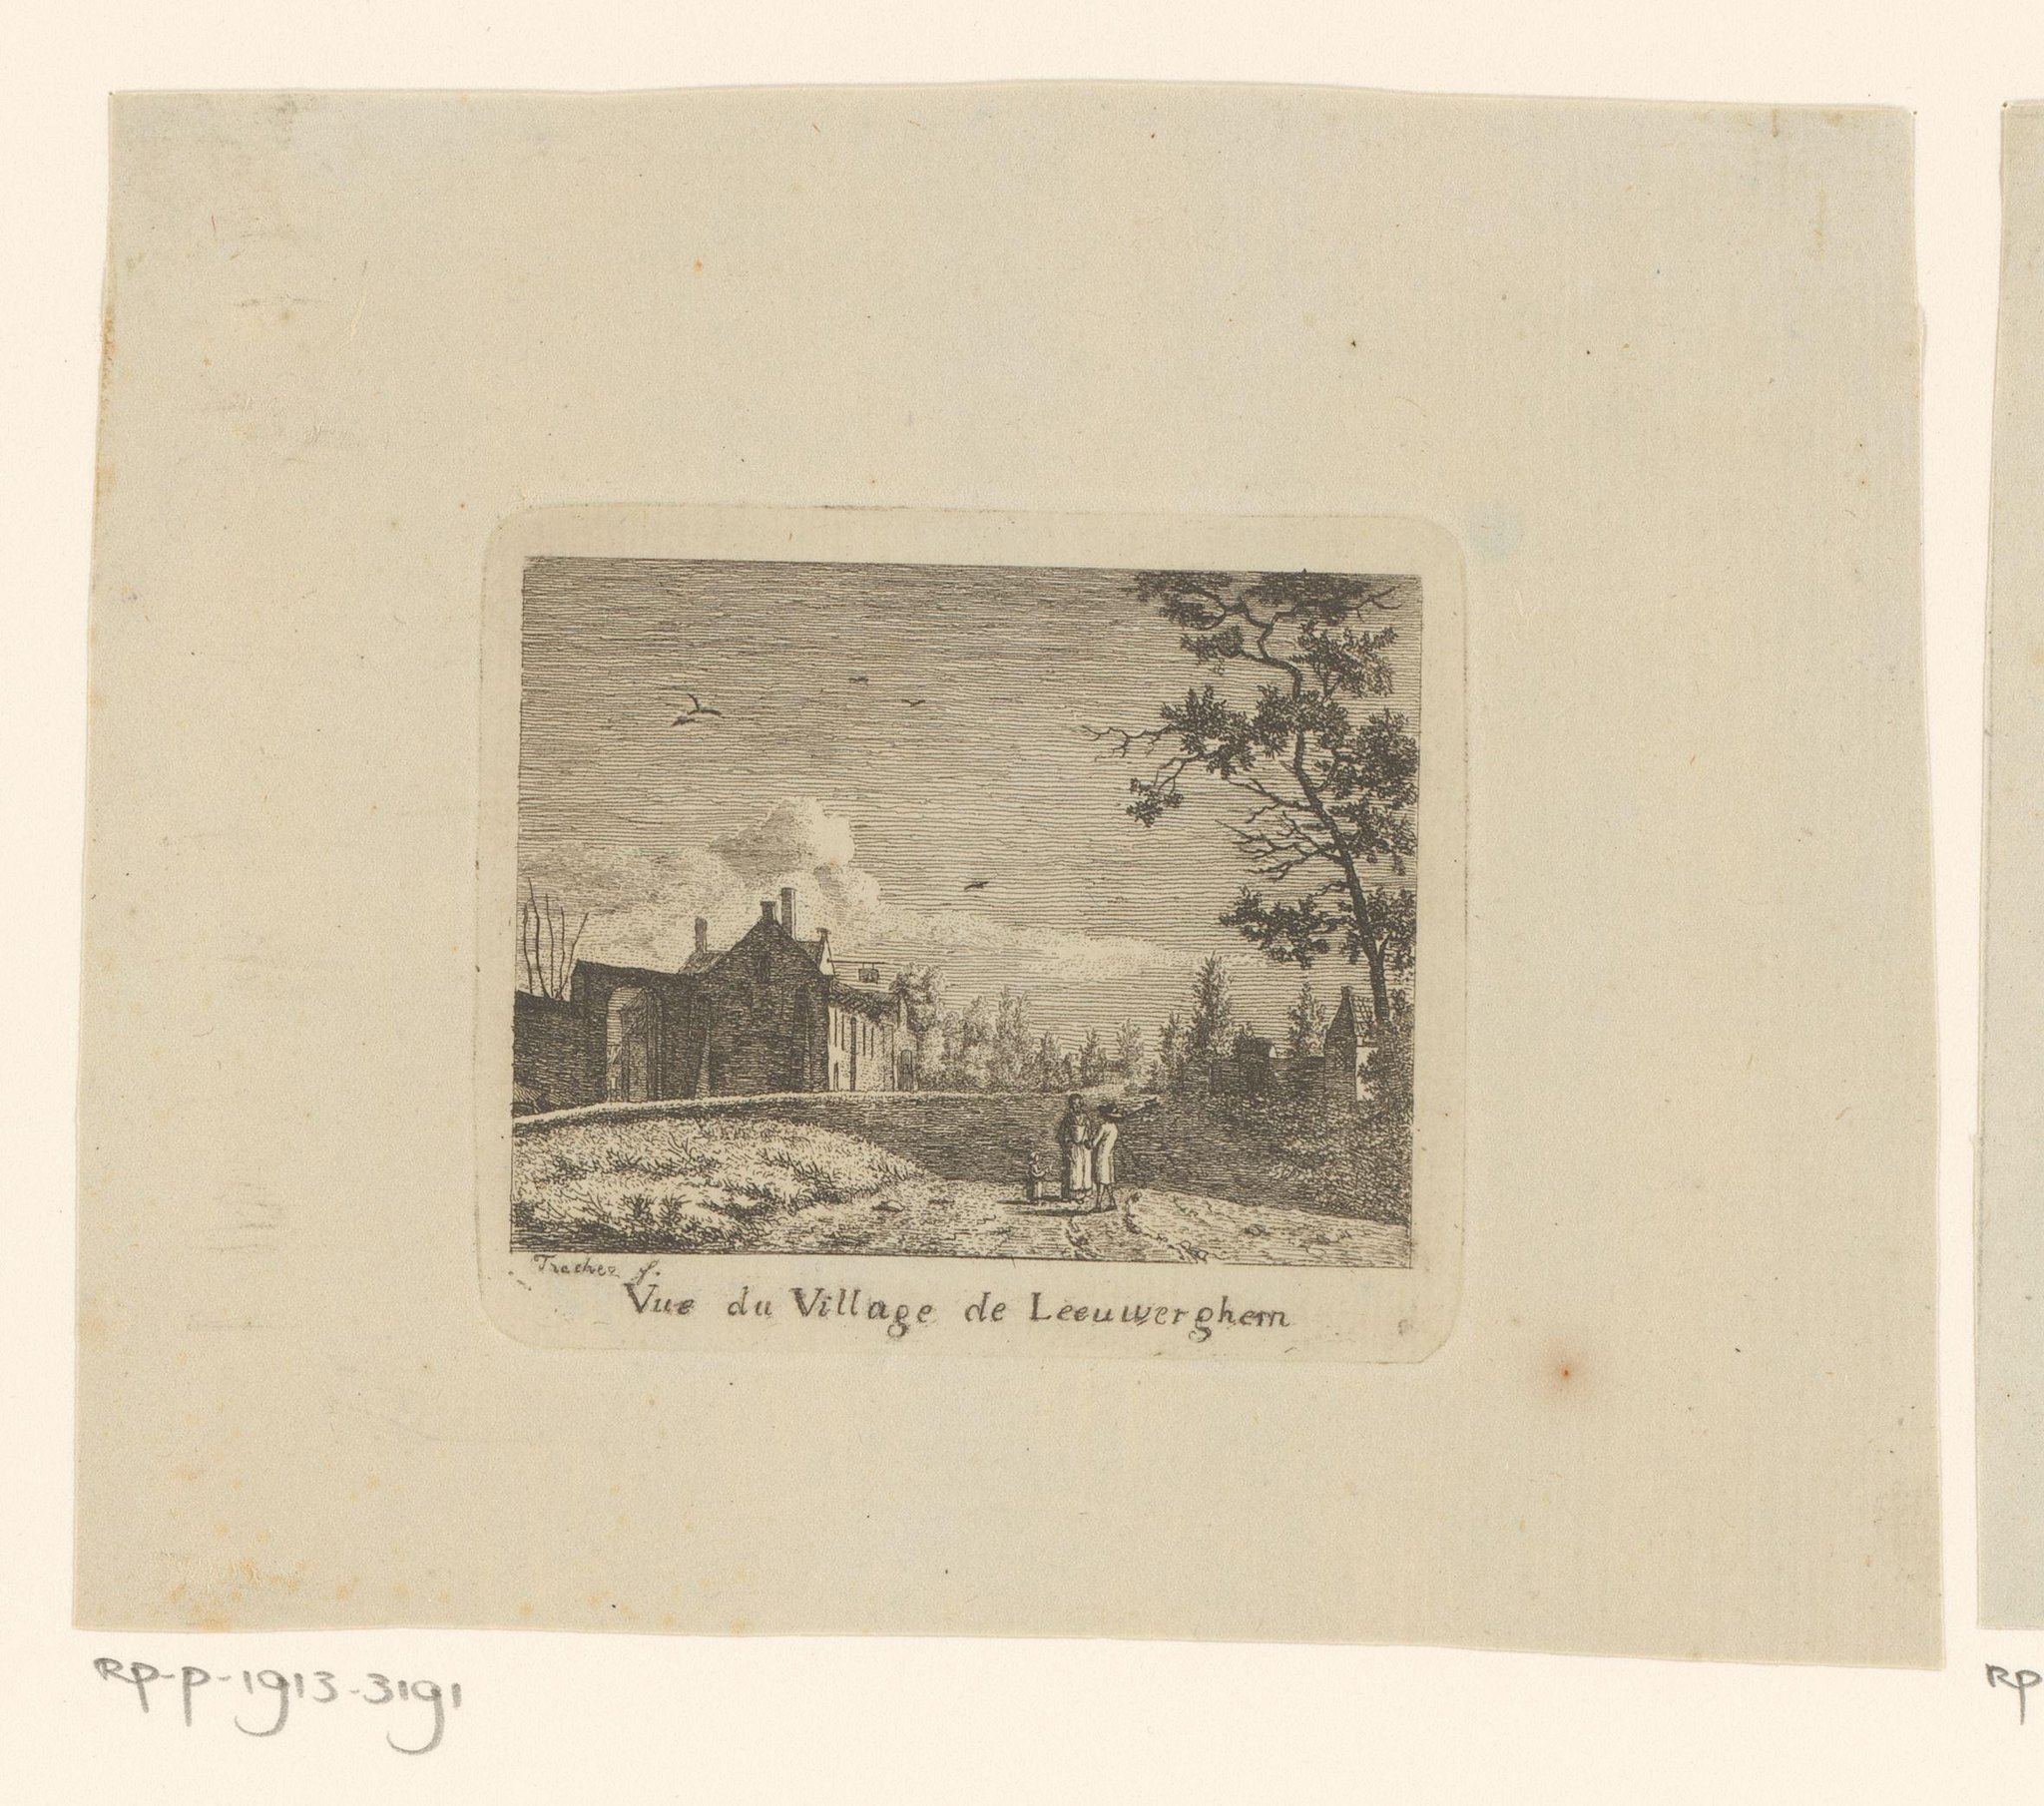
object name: print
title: Vier gezichten op het dorp Leeuwergem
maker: jacques andré joseph trachez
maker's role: print maker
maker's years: 1746-1820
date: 1790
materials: paper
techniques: etching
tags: prospect of village, silhouette of village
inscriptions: collector's mark: Lugt 2228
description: De prenten in deze serie zijn ongenummerd.